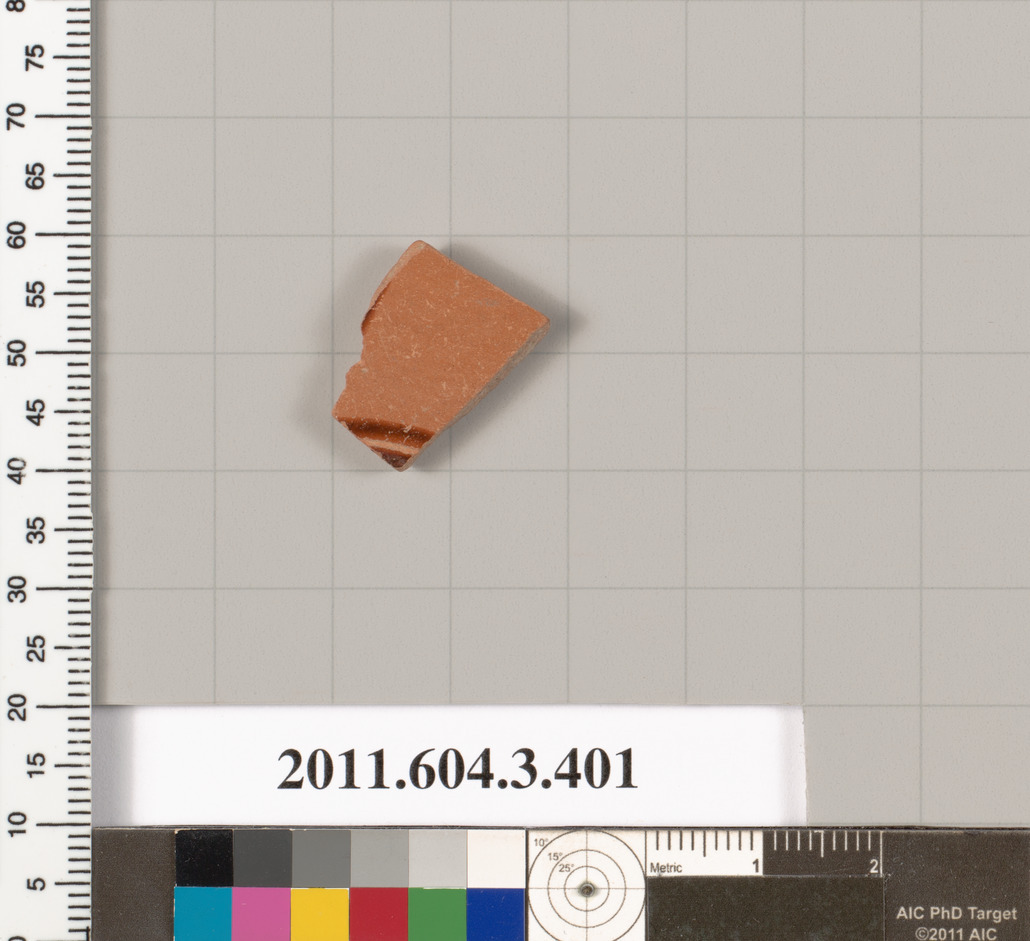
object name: neck amphora fragment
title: Terracotta fragment of a neck-amphora (jar)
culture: greek, attic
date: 500-468 BCE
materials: terracotta